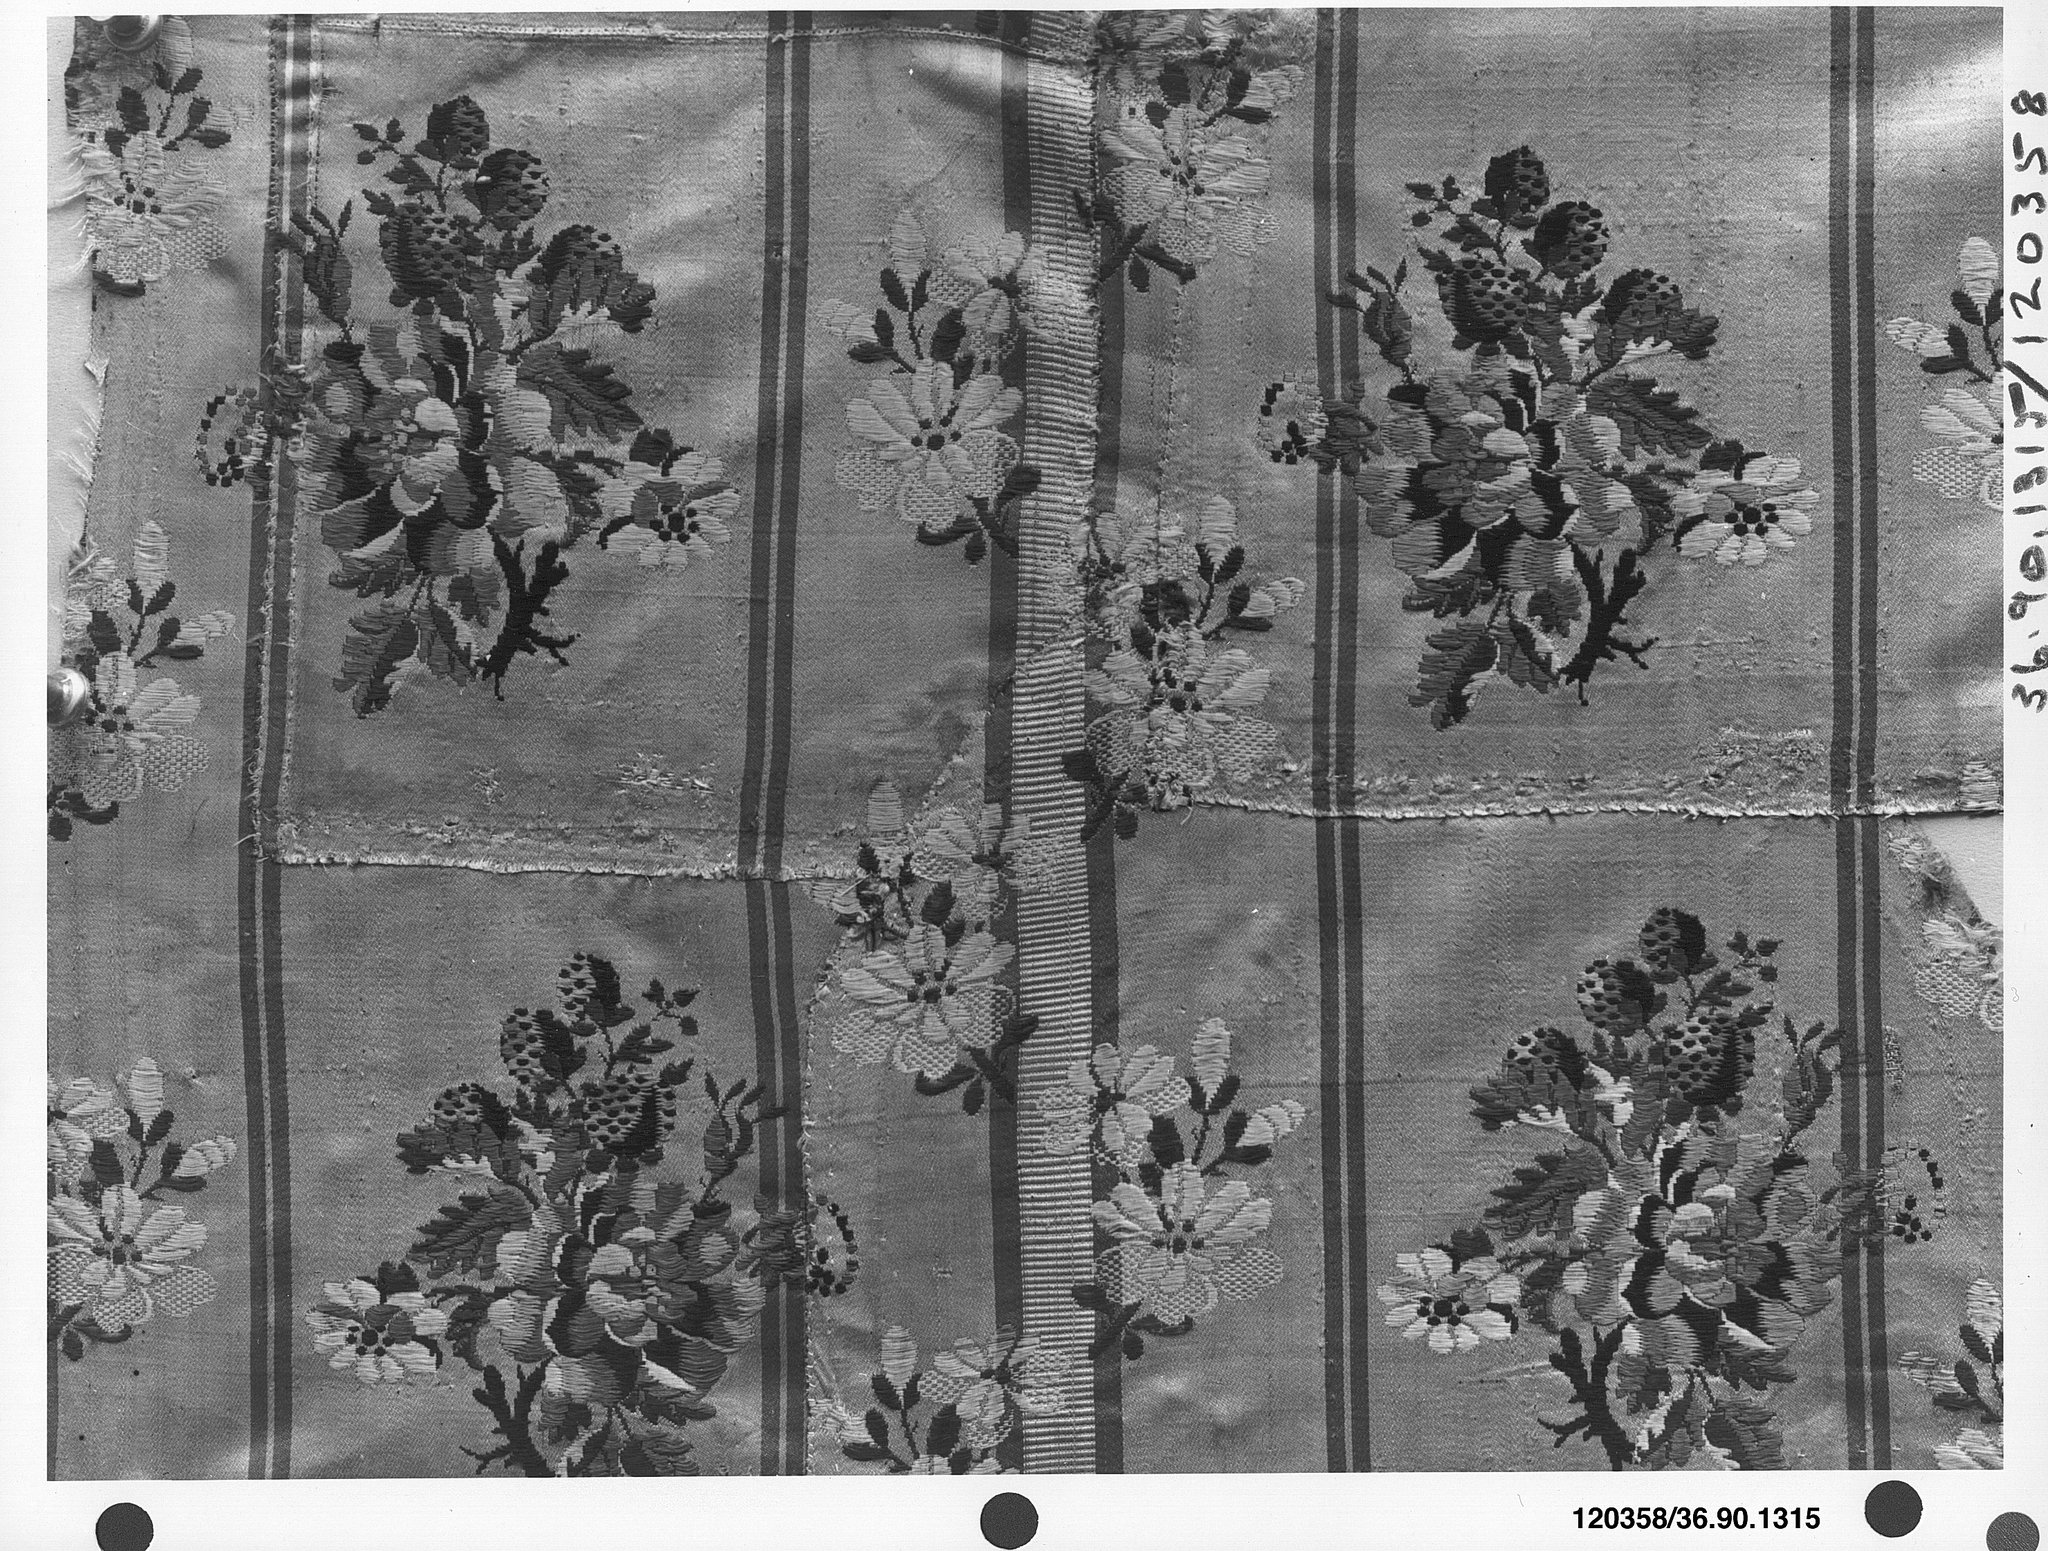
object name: piece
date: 1701-1800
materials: silk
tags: flowers,leaves